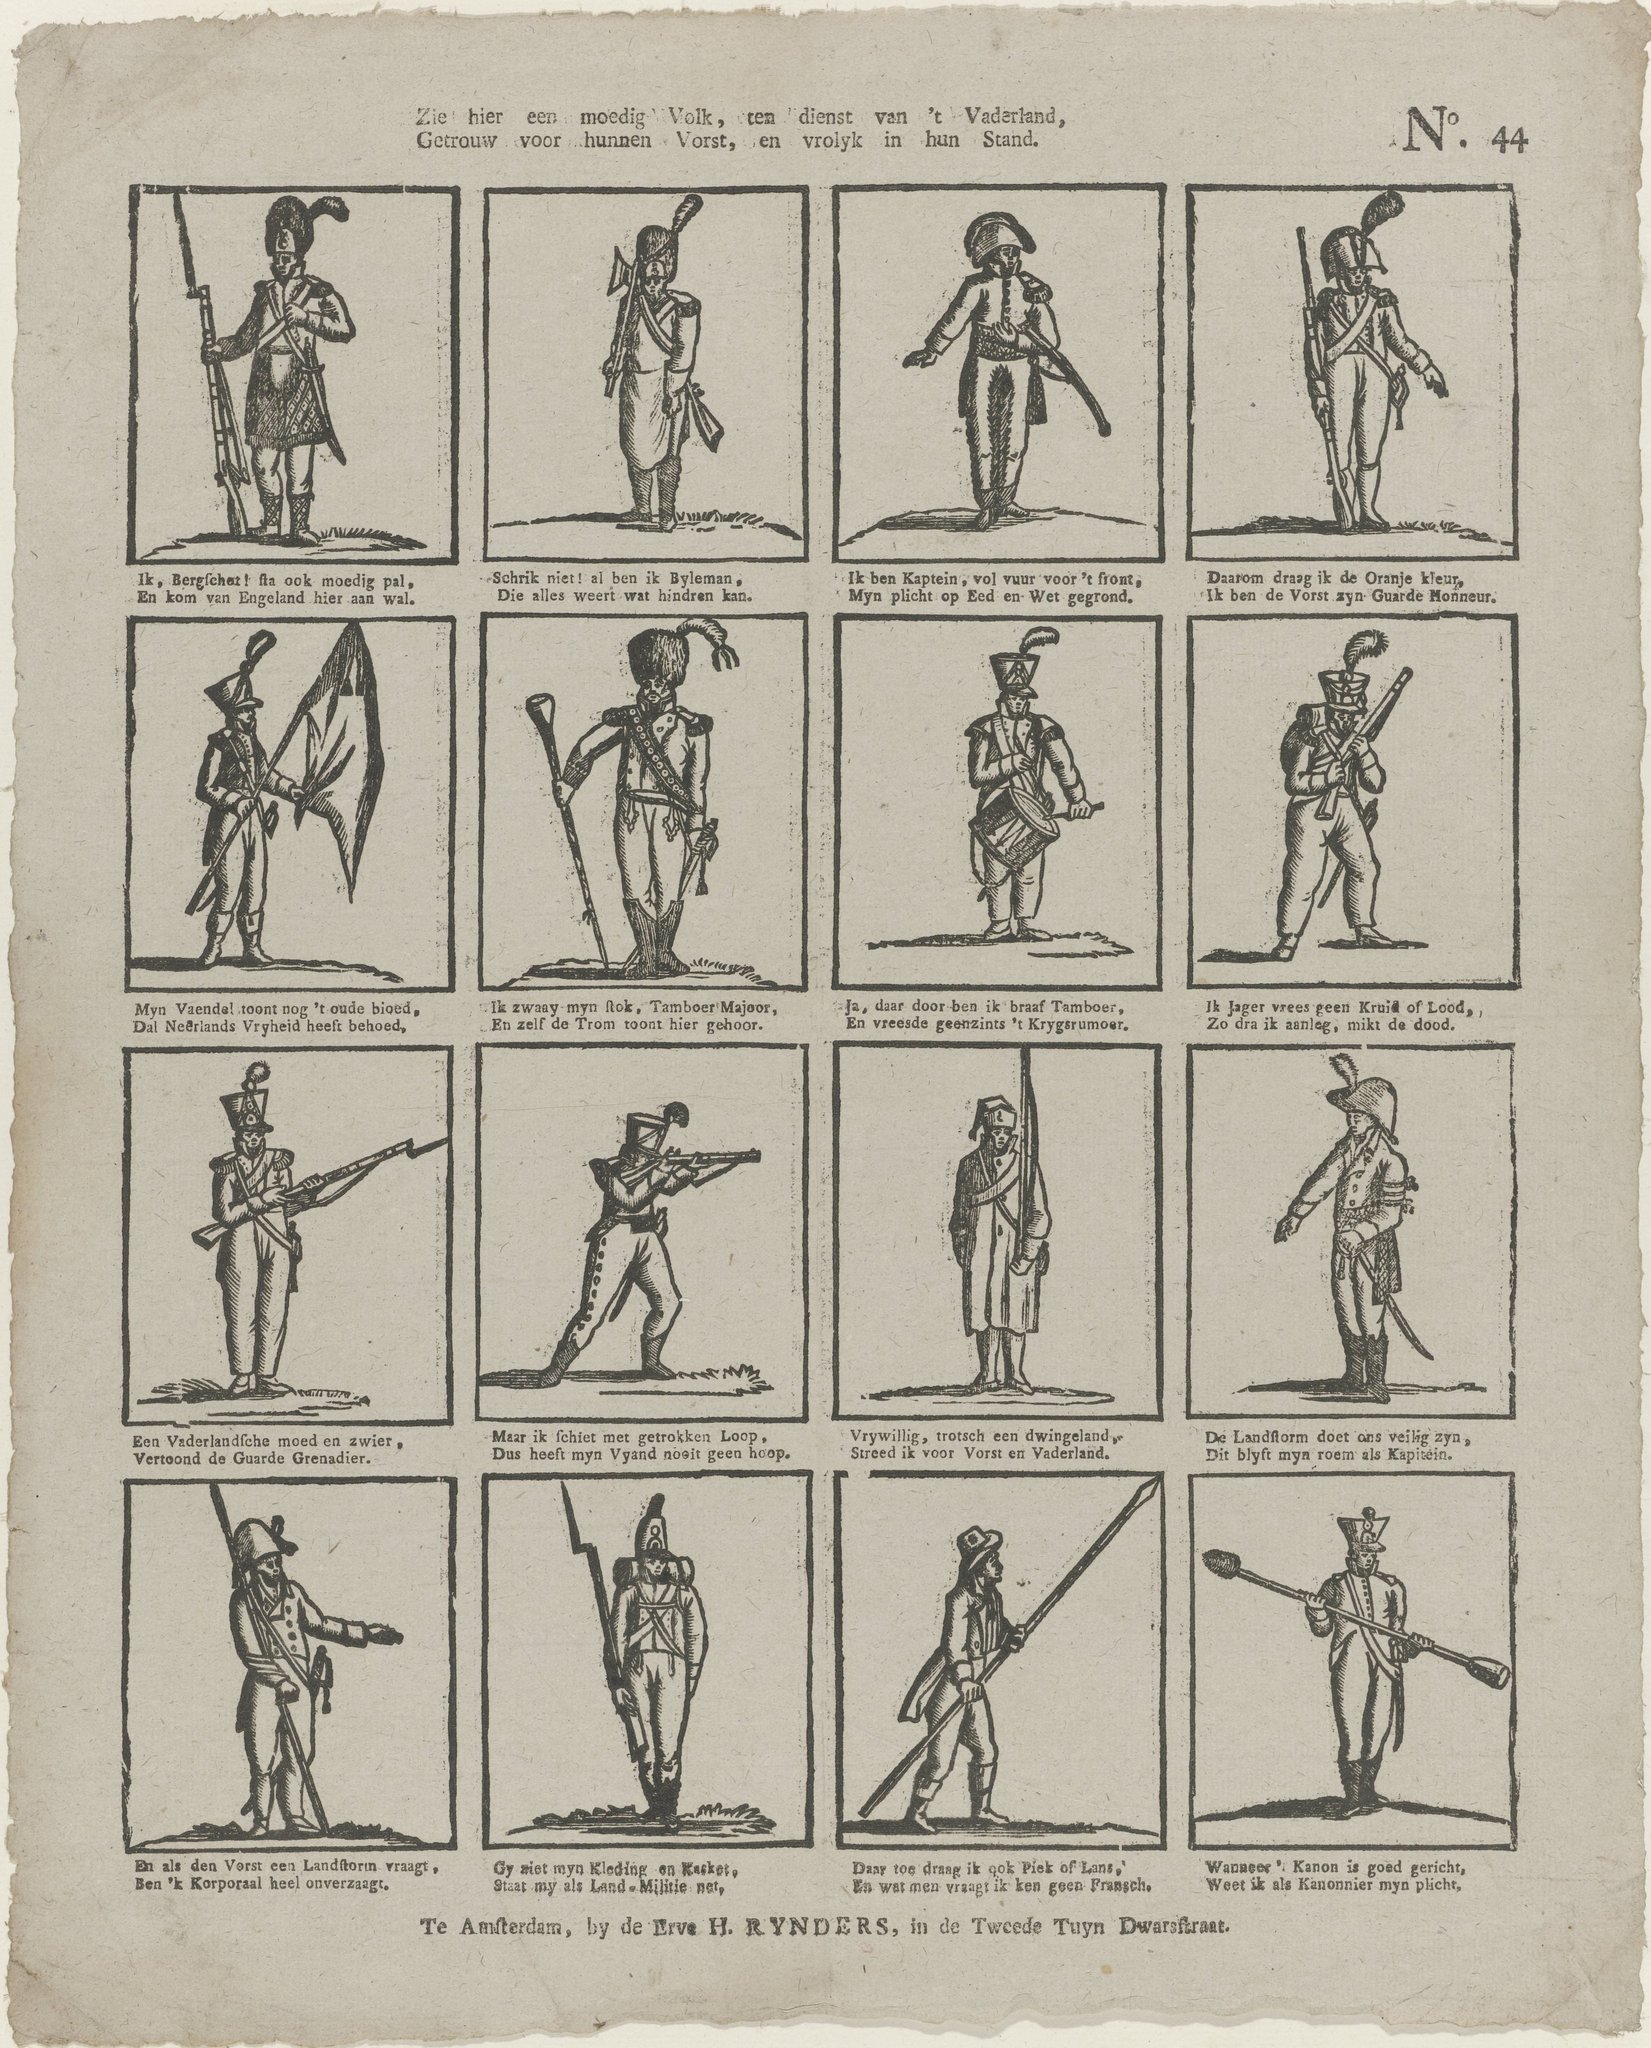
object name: popular print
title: Zie hier een moedig volk, ten dienst van 't vaderland, / Getrouw voor hunnen vorst, en vrolyk in hun stand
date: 1831-1854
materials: paper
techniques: letterpress printing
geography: netherlands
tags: artillery range, firing range, shooting range ~ military training, the soldier; the soldier's life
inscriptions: collector's mark: Lugt 2760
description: Blad met 16 voorstellingen van militairen. Onder elke afbeelding een tweeregelig vers. Genummerd rechtsboven: No. 44.